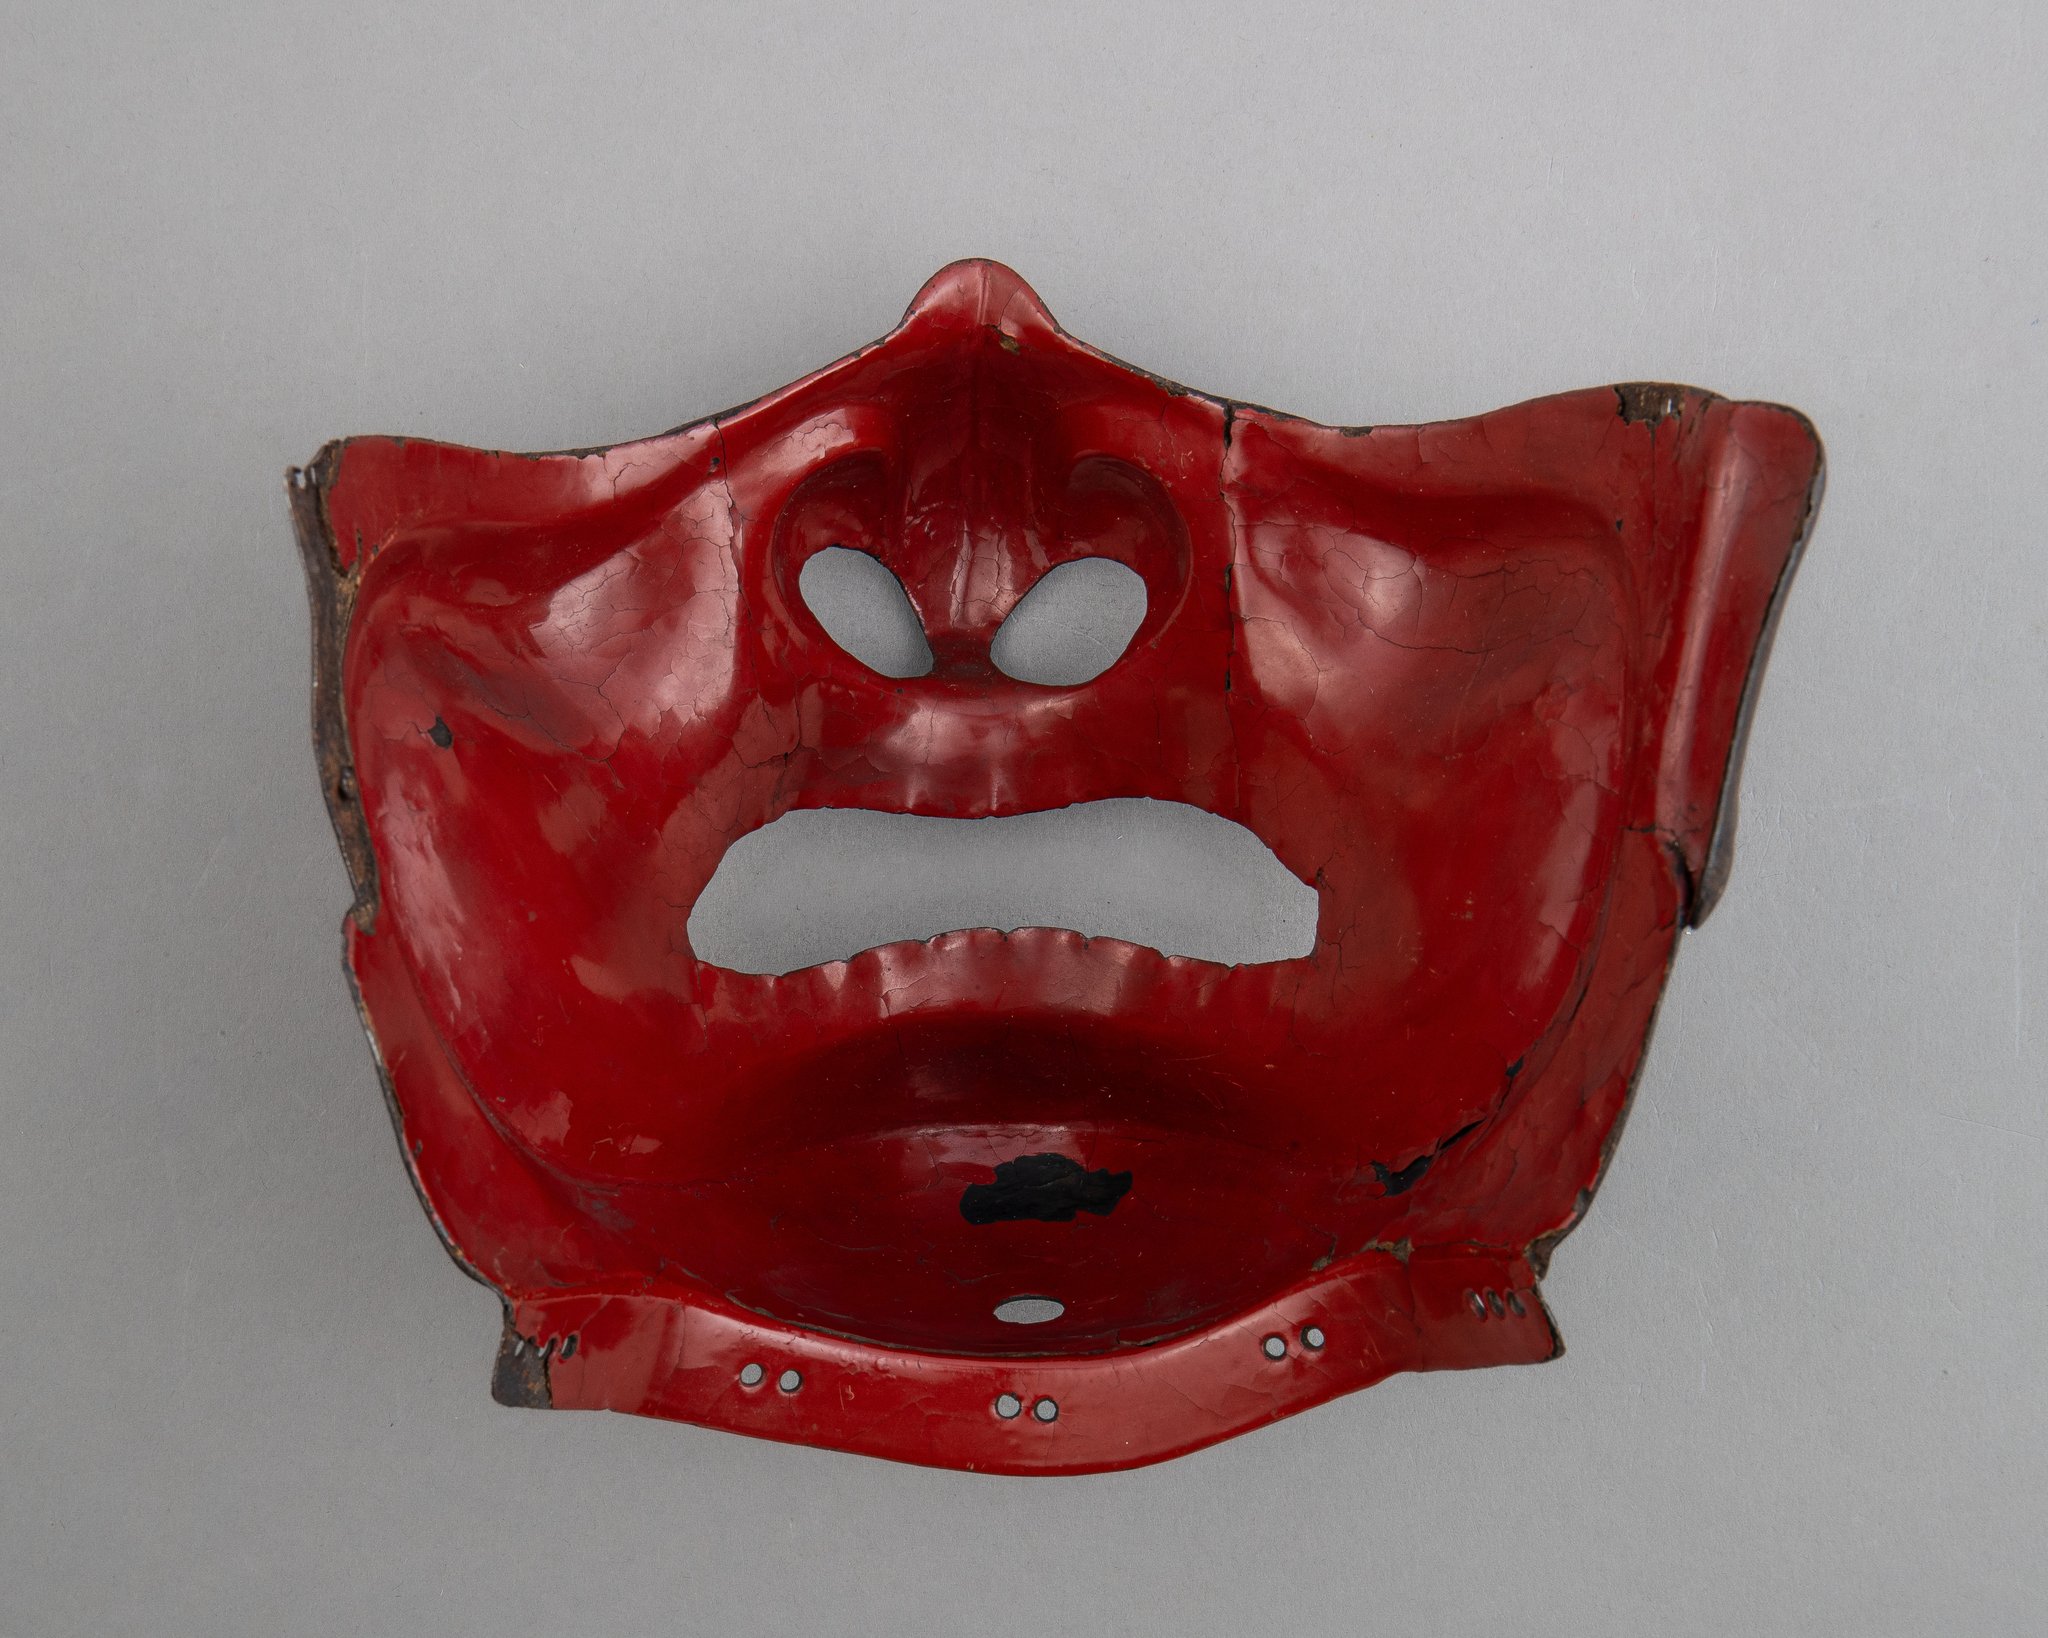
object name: half mask menpō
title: Half Mask (Menpō)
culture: japanese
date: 1615-1868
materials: iron, lacquer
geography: japan